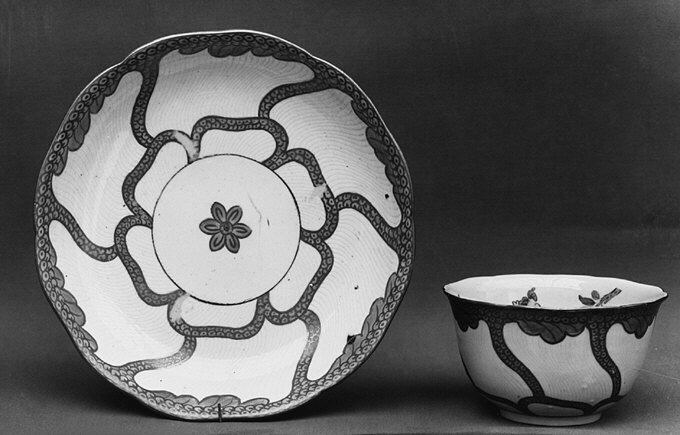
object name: cup and saucer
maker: ludwigsburg porcelain manufactory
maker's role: manufactory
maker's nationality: german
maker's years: 1758-1824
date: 1701-1900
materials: hard paste porcelain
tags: flowers